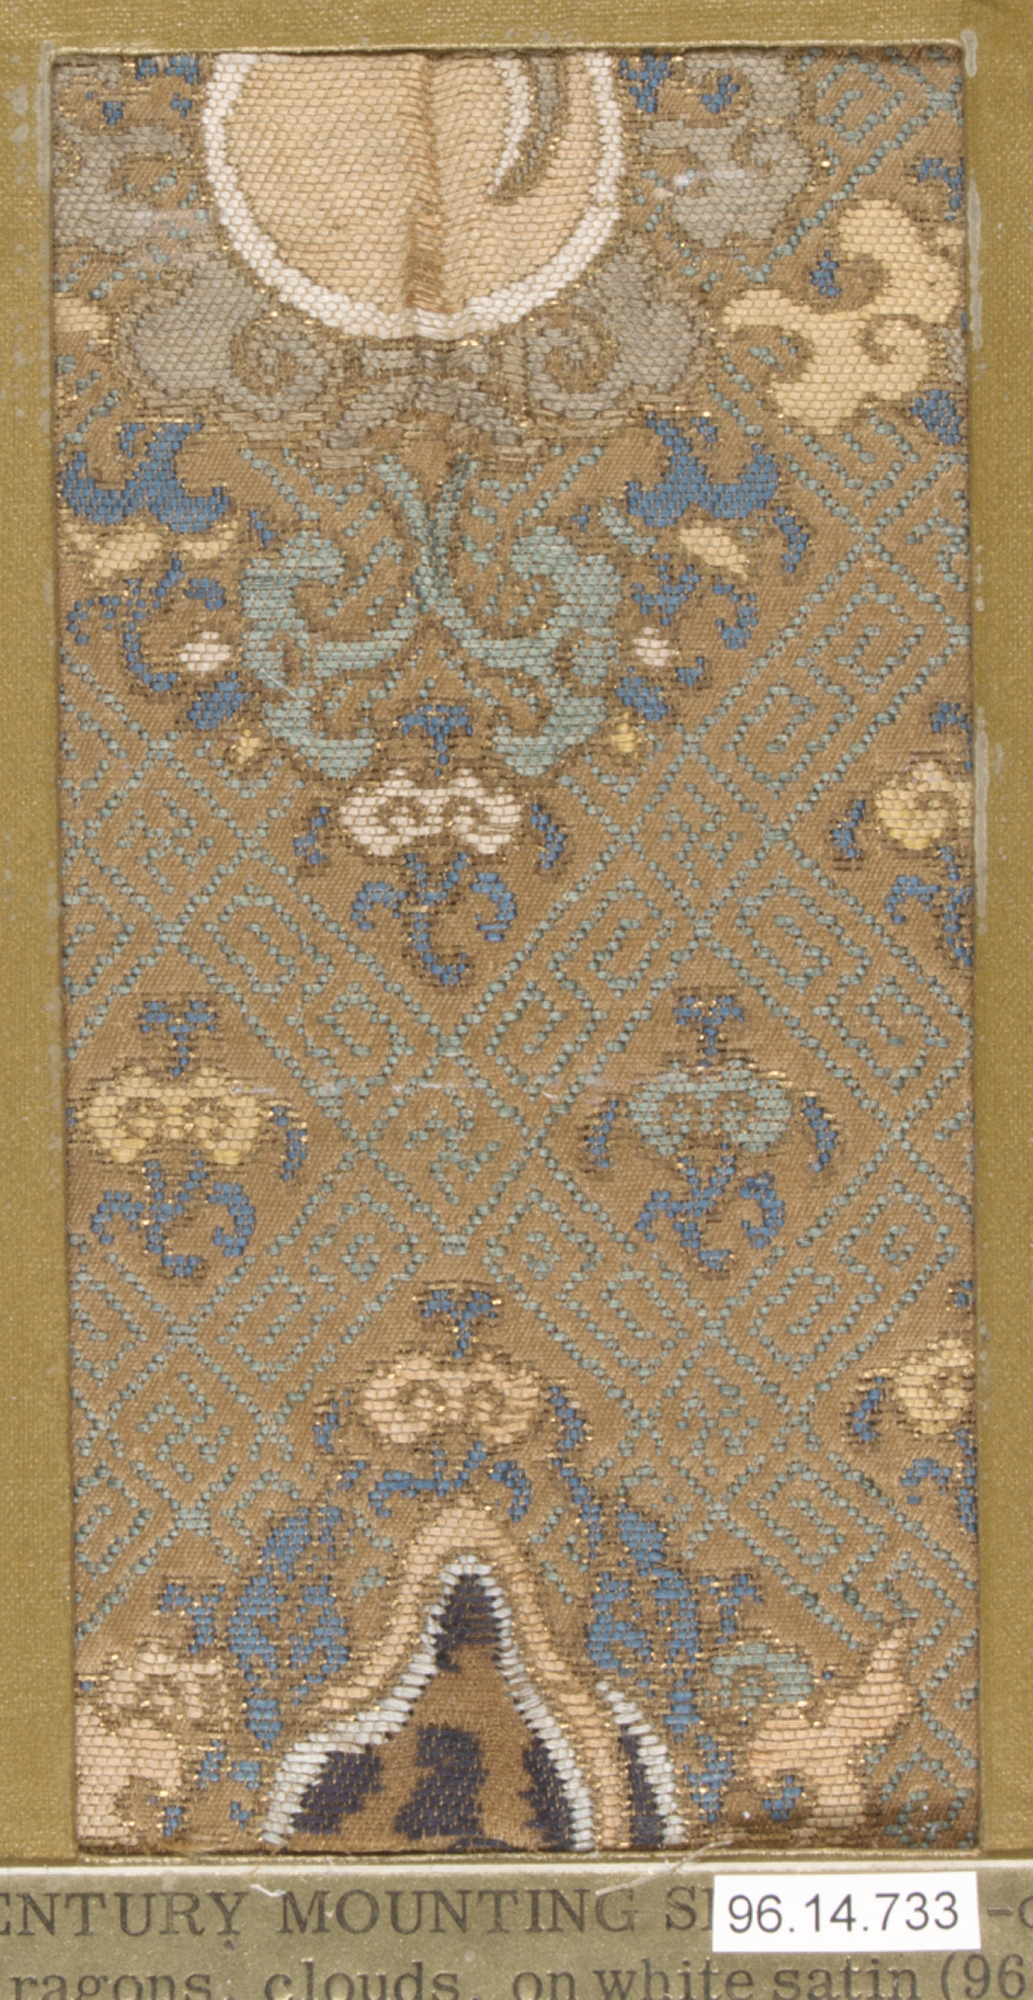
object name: piece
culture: japanese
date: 1701-1900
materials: silk